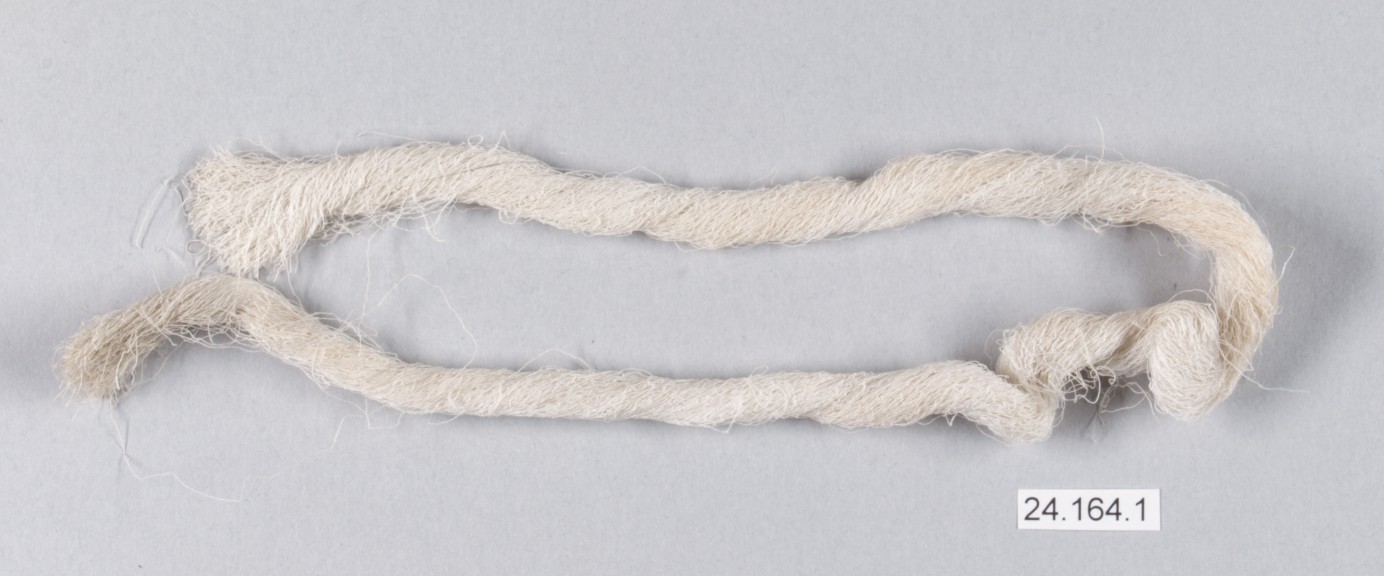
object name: skein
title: Skeins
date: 1701-1800